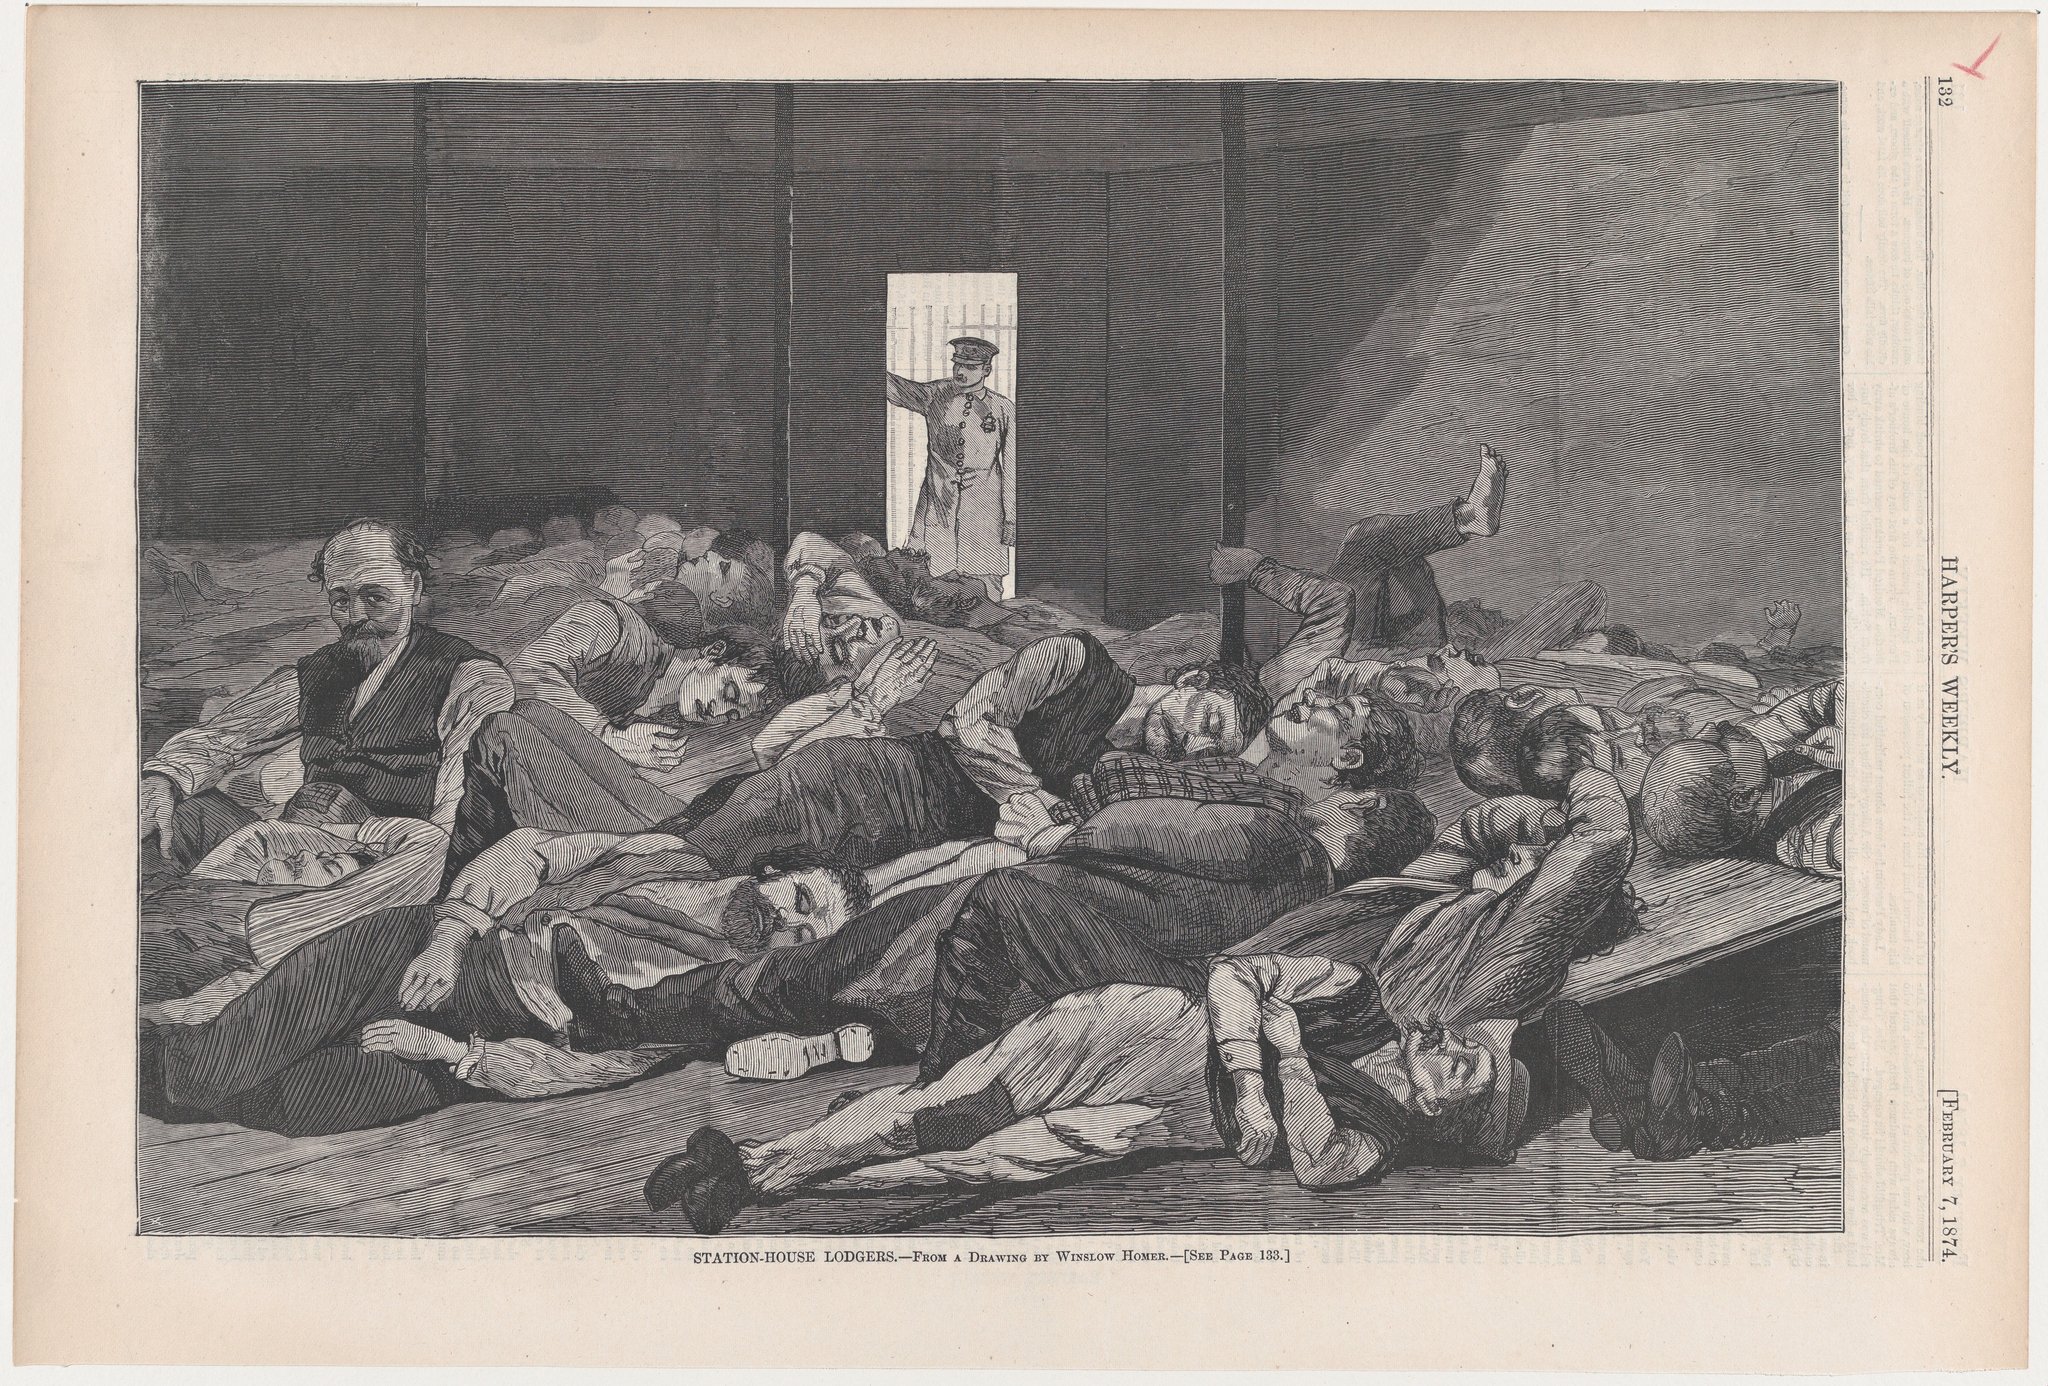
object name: print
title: Station-House Lodgers (from "Harper's Weekly," Vol. XVIII)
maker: winslow homer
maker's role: artist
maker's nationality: american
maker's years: 1836-1910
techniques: engraving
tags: sleeping,men